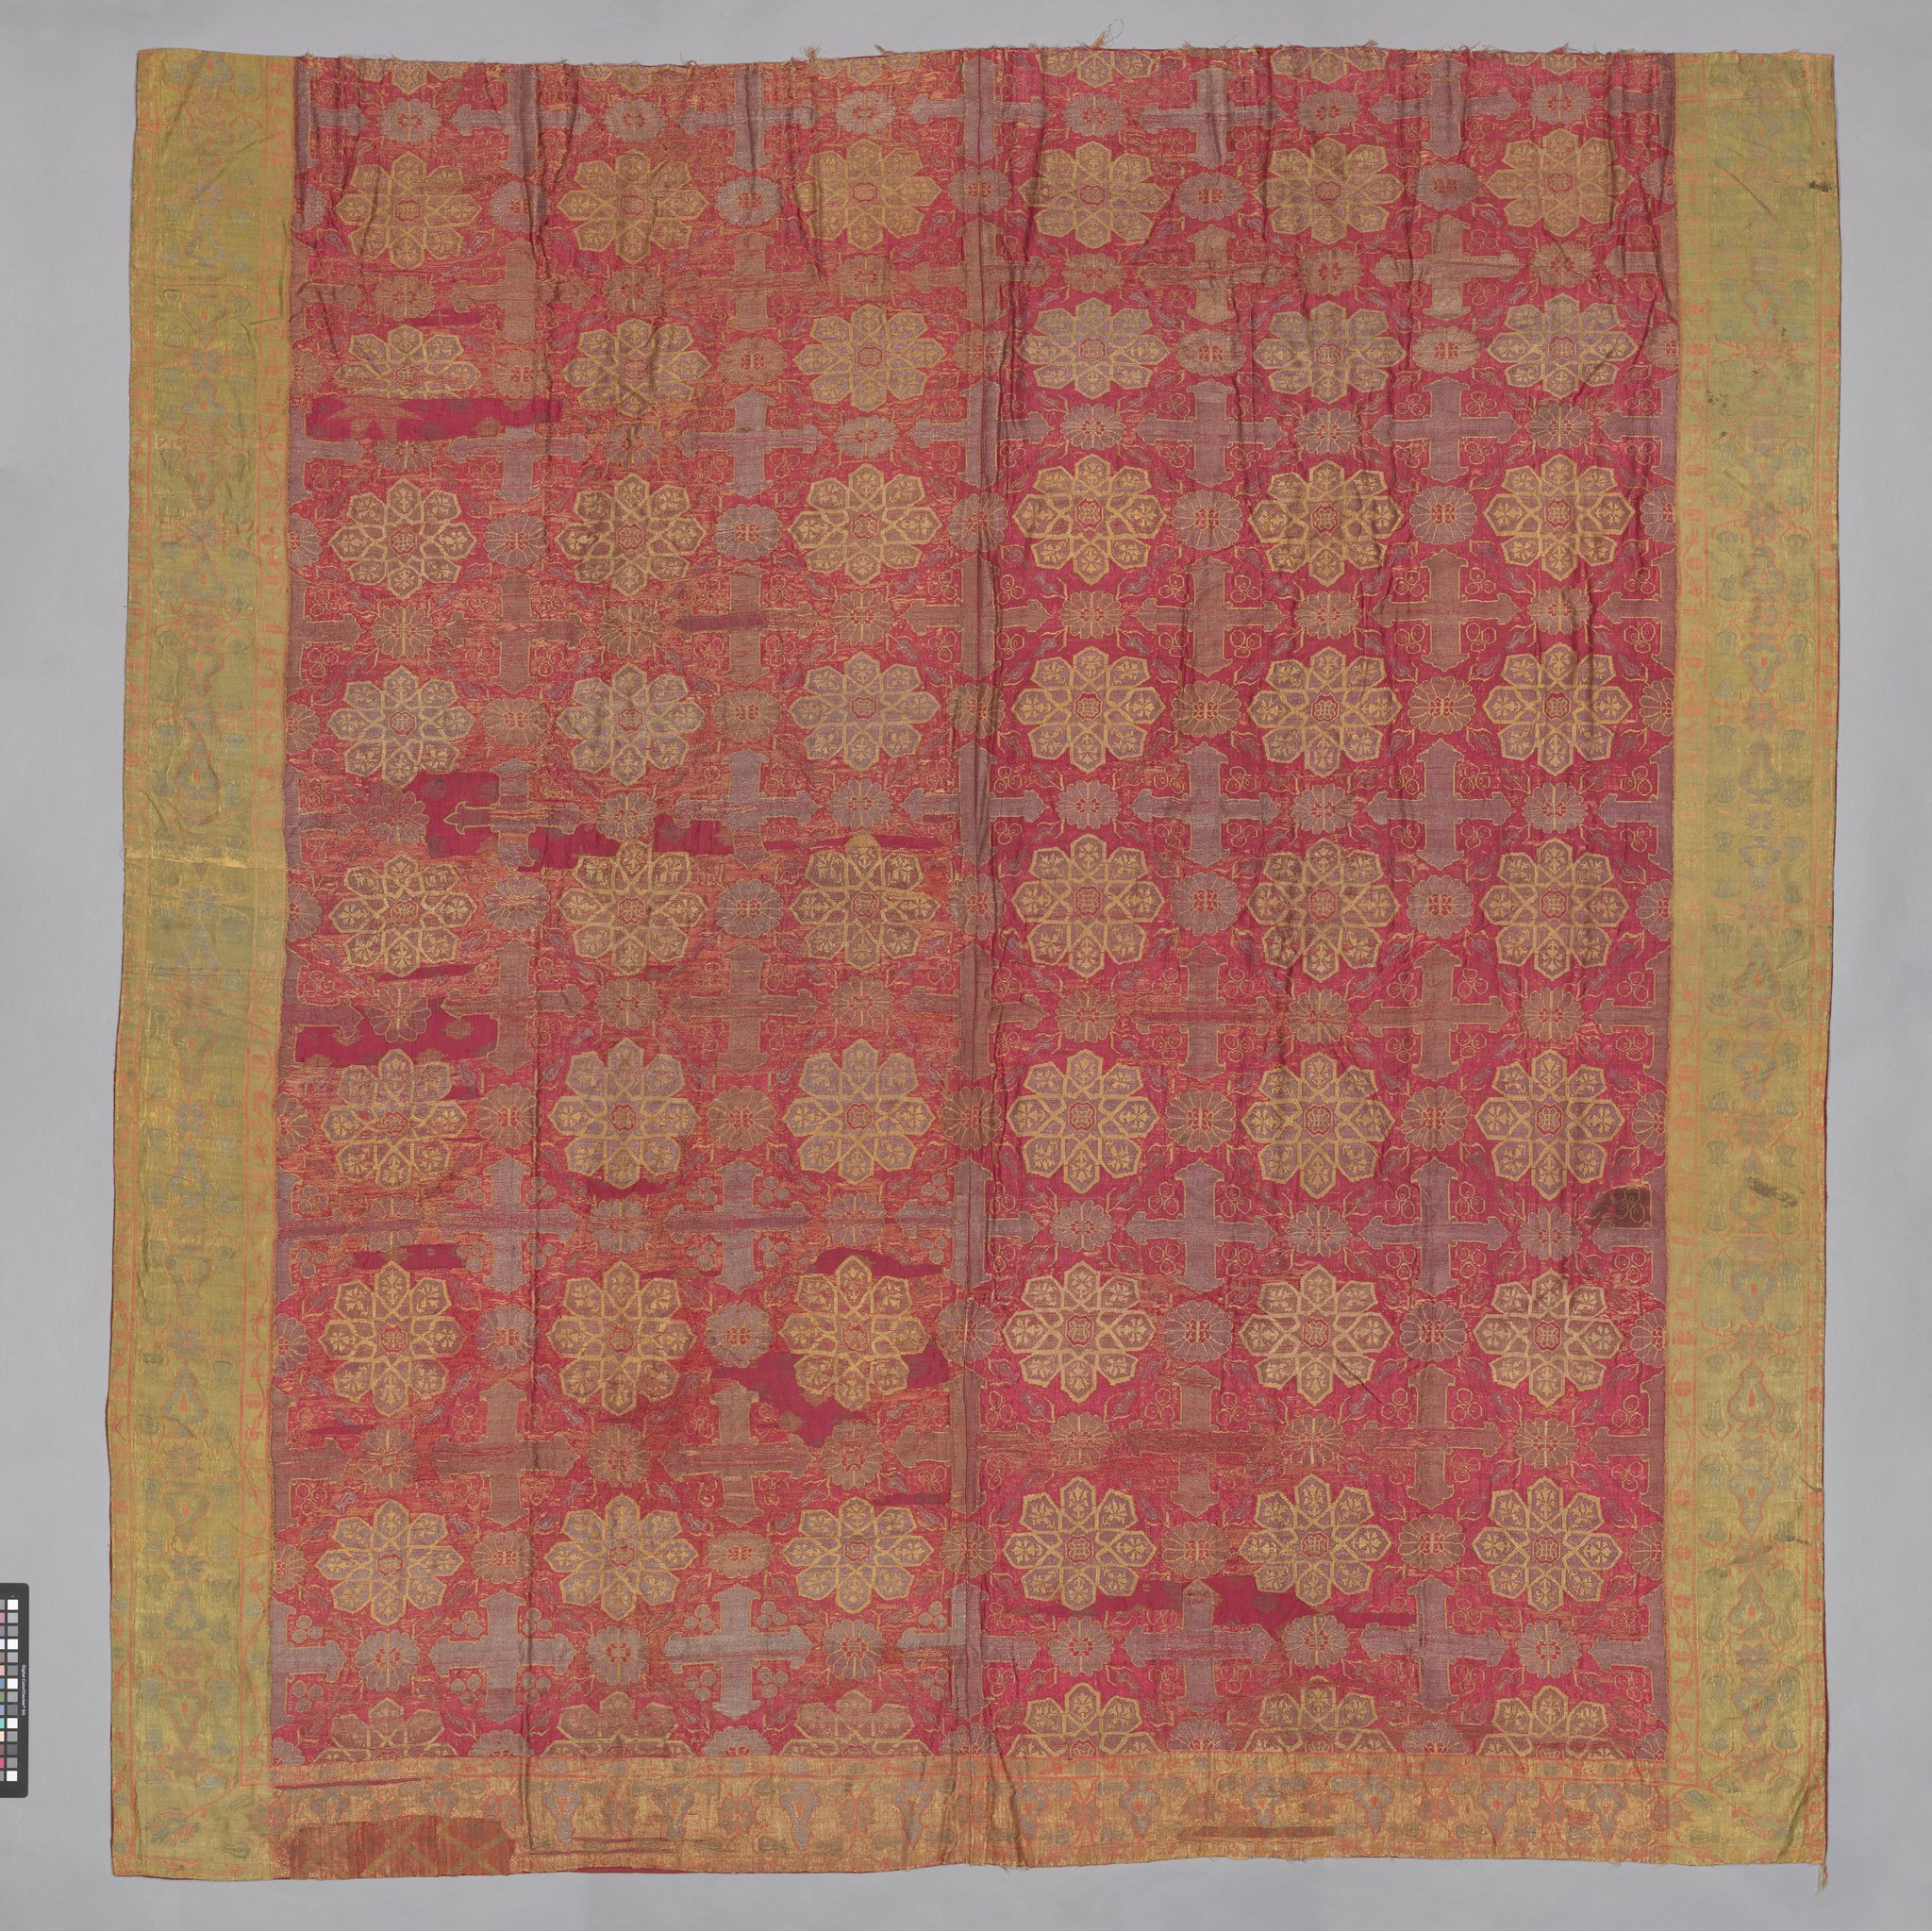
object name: hanging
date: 1701-1800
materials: gold, silk, silver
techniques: brocade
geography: armenia